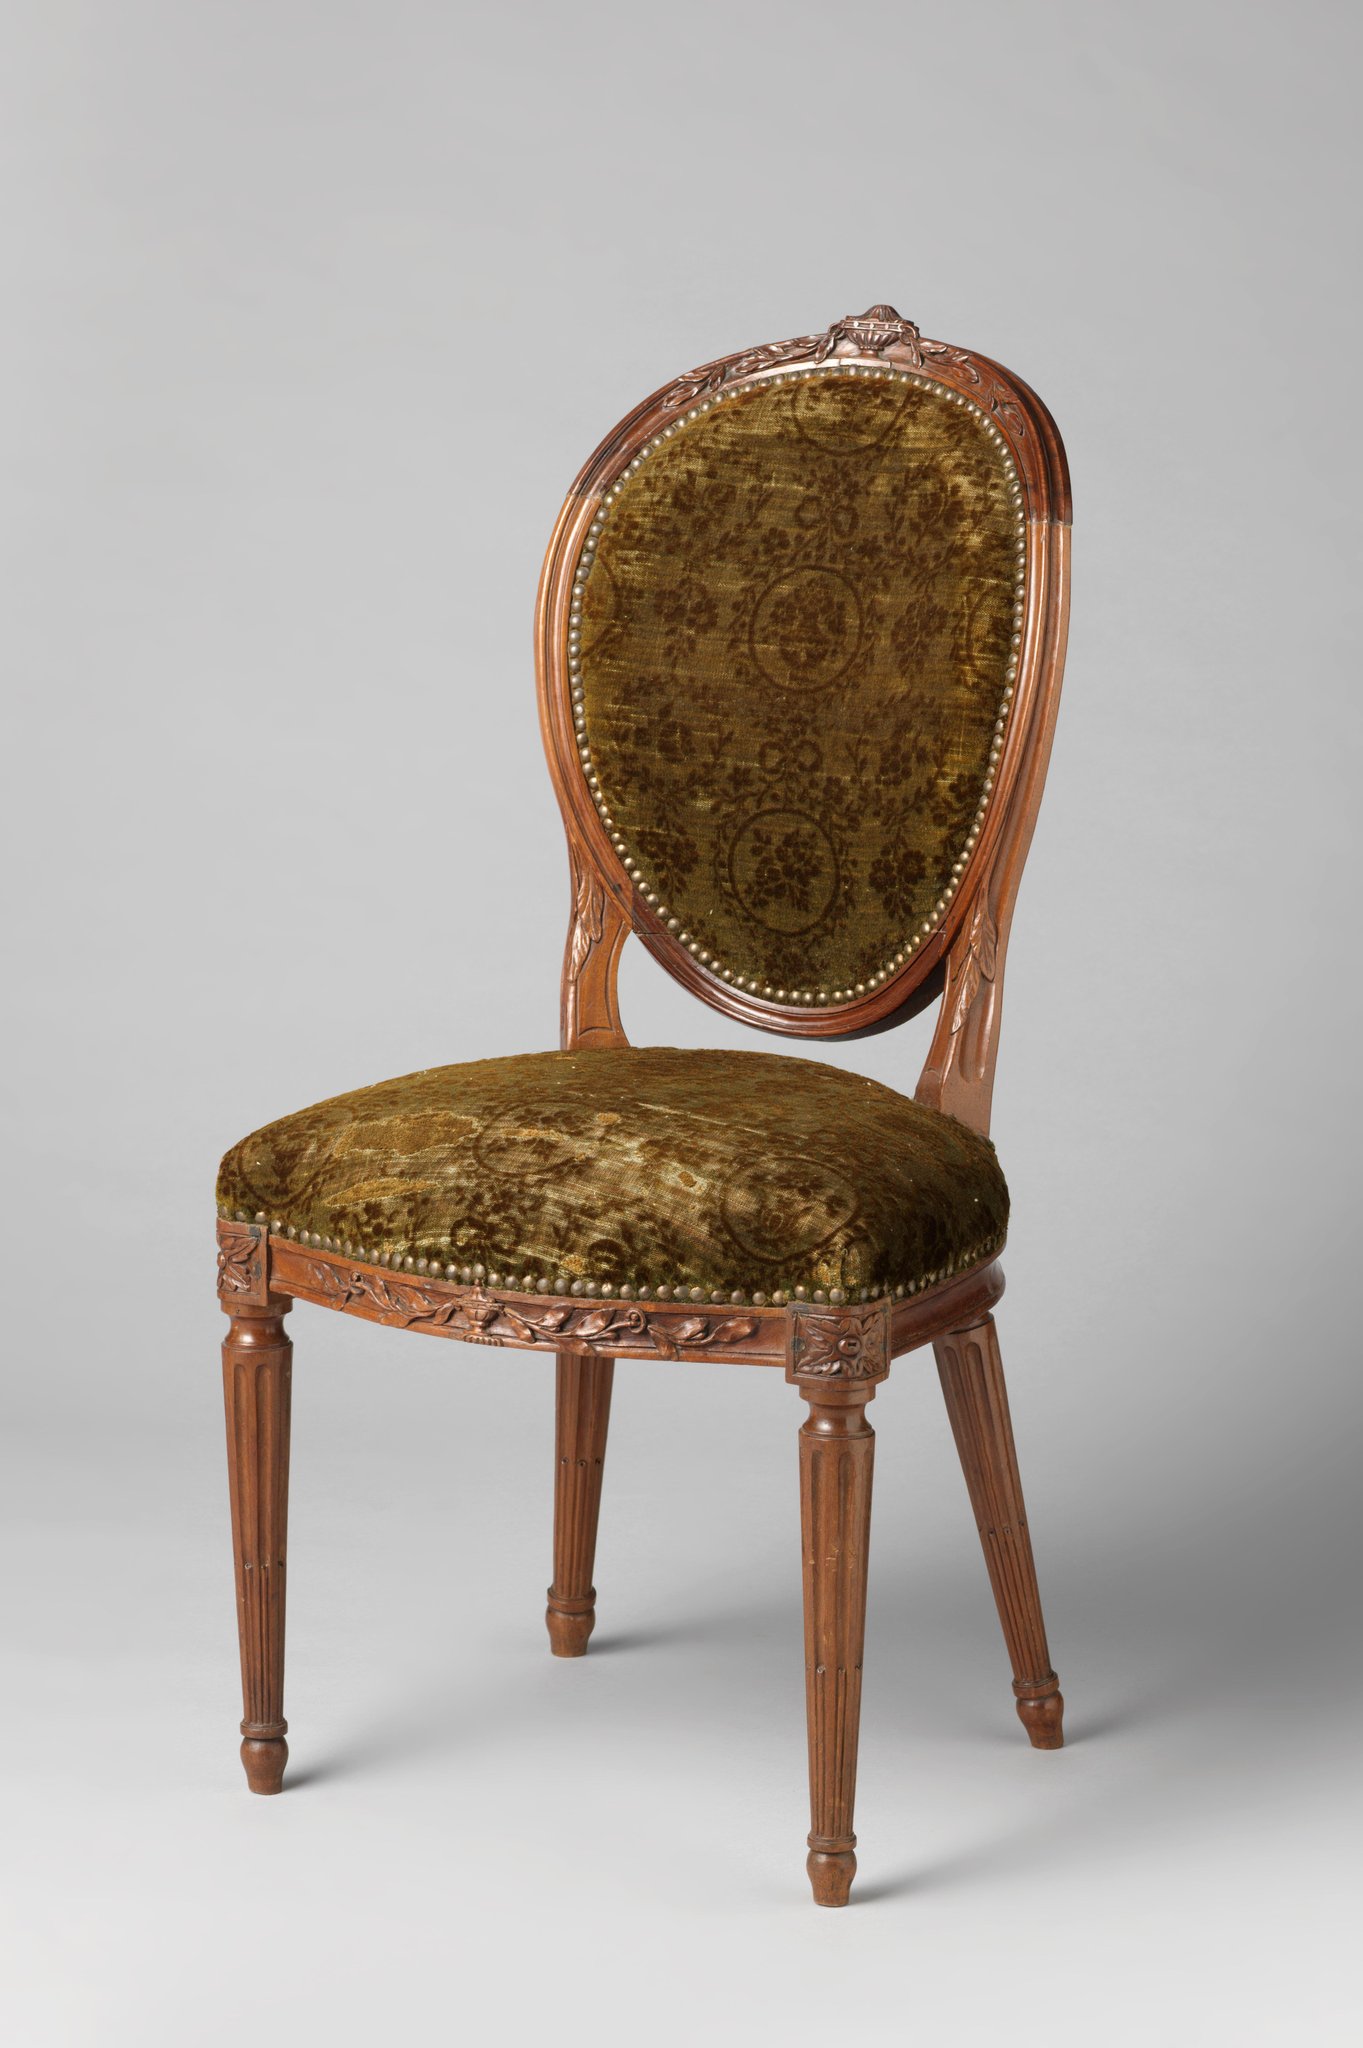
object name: armchair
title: Armstoel van mahoniehout, bekleed met groene trijp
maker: Anonymous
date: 1775-1800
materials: wood, textile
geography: northern netherlands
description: Armchair. Mahogany, the velvet upholstery has been renewed. Netherlands, c. 1780 - 1800. Given by Mr and Mrs Drucker-Fraser, 1922.